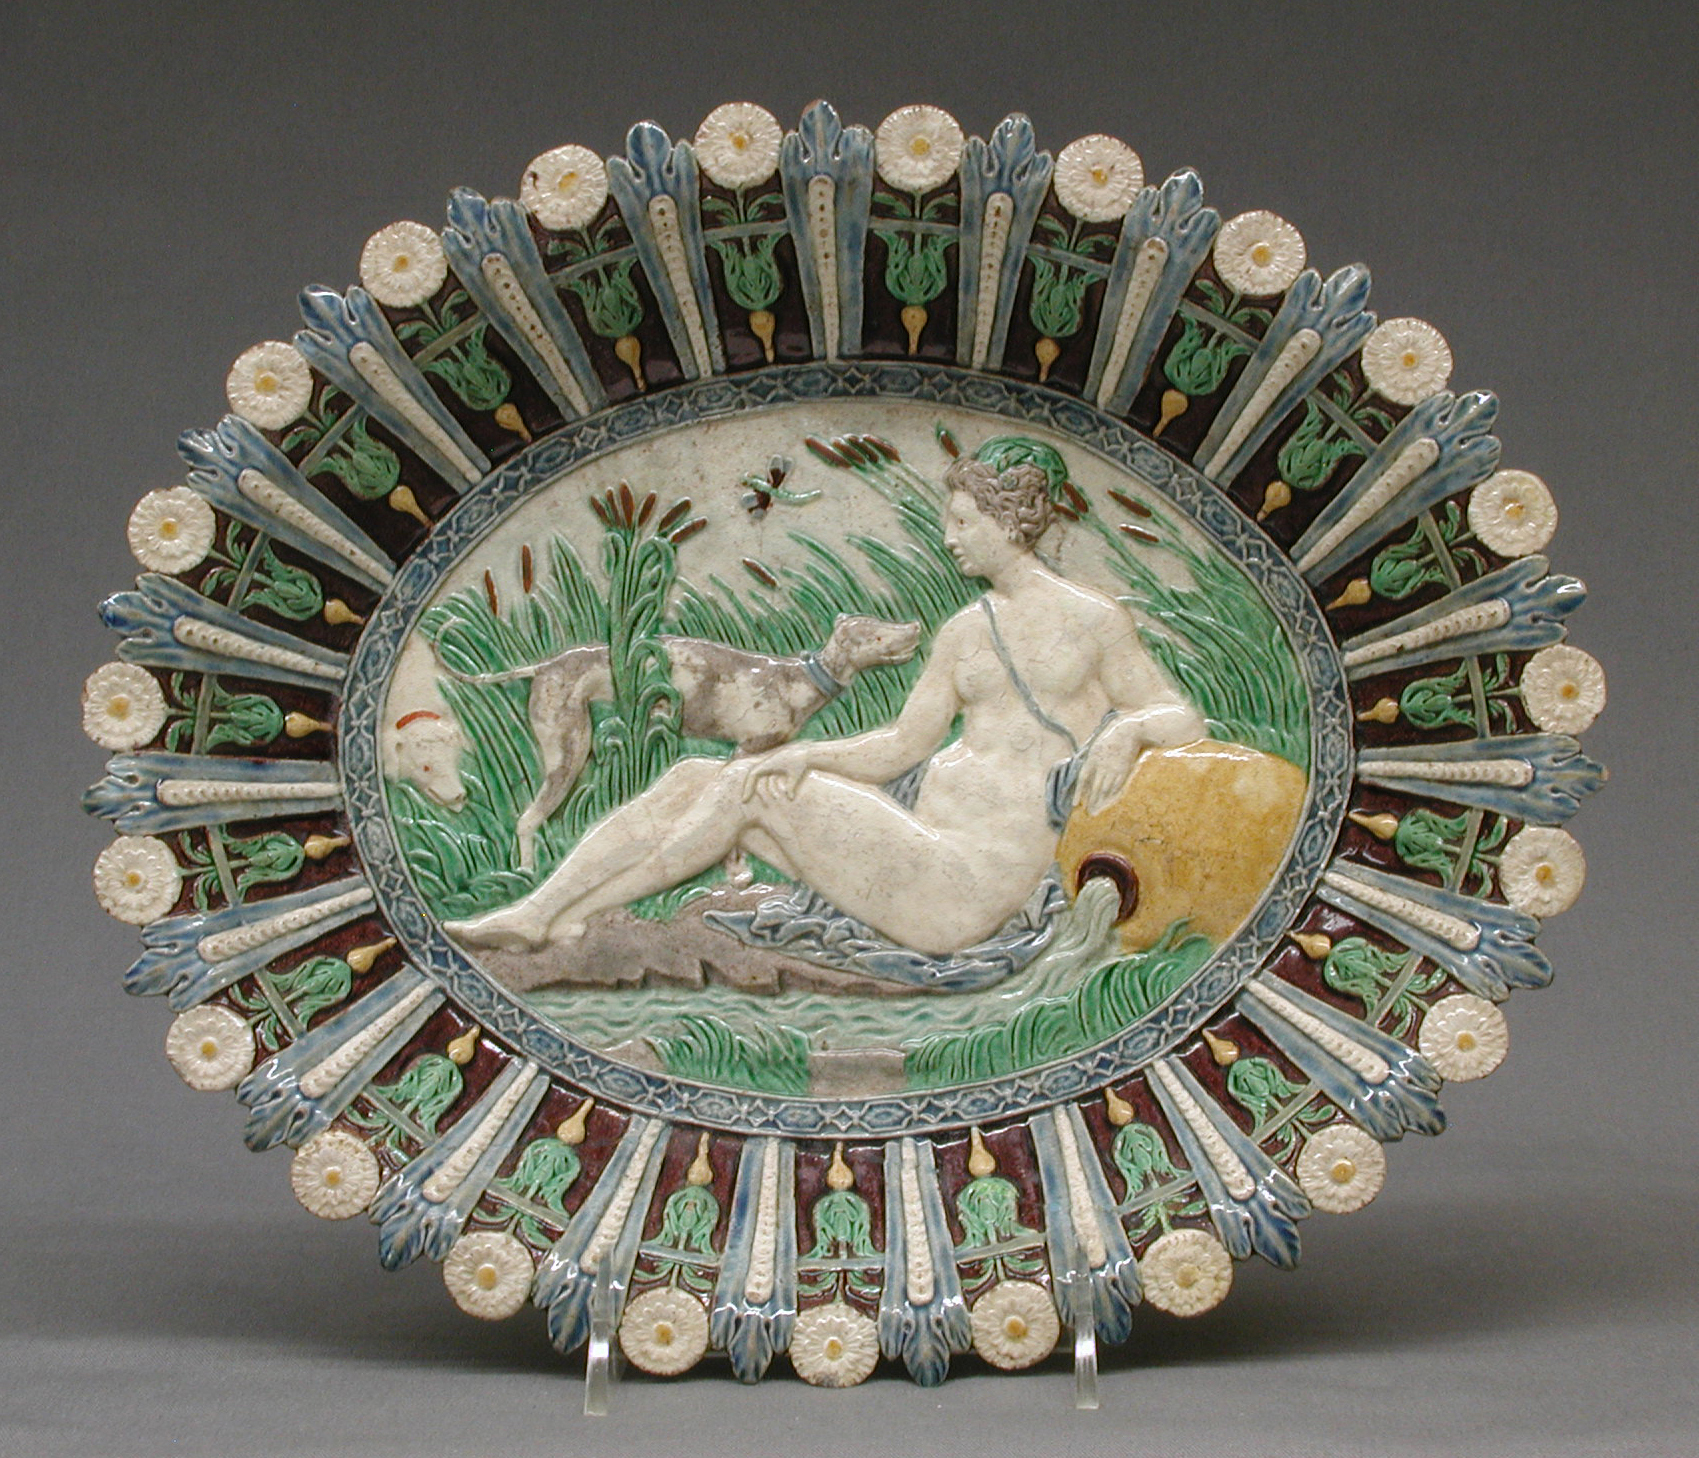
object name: dish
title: Dish with Diana, the Nymph of Fontainebleau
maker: bernard palissy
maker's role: maker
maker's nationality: french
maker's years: 1510-1590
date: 1567-1633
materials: earthenware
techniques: glazing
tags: diana,dogs